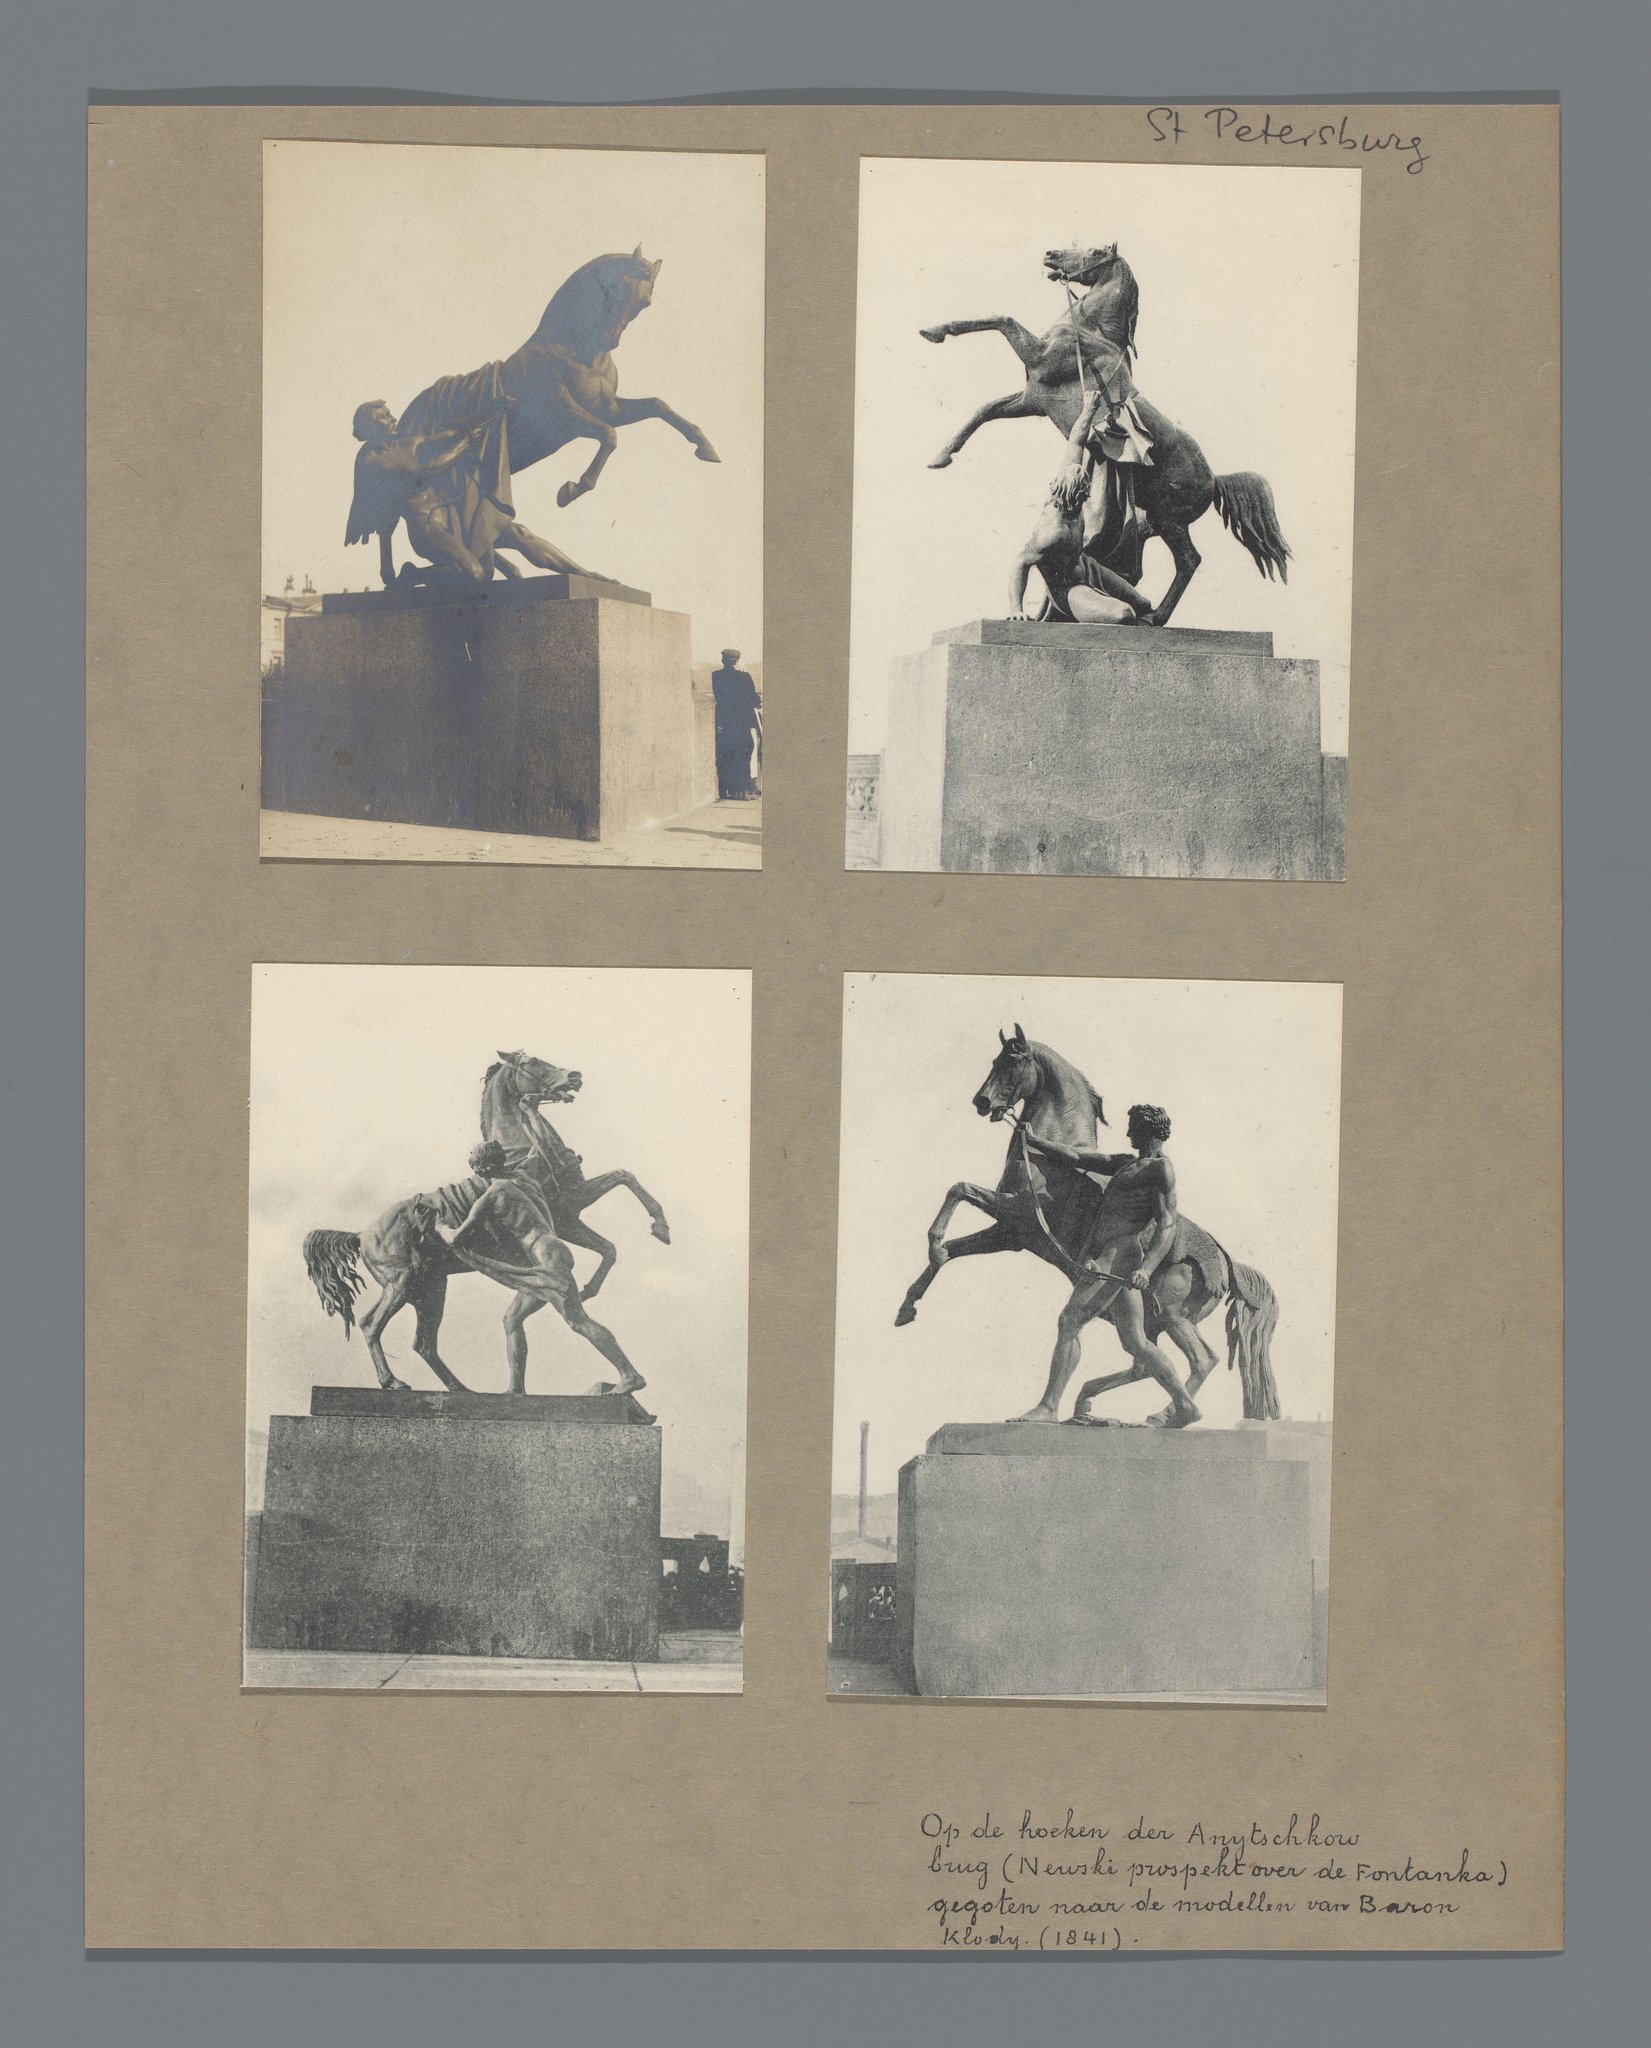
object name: photograph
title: St. Petersburg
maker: Anonymous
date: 1860-1925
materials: photographic support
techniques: photograph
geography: russia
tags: sint-petersburg